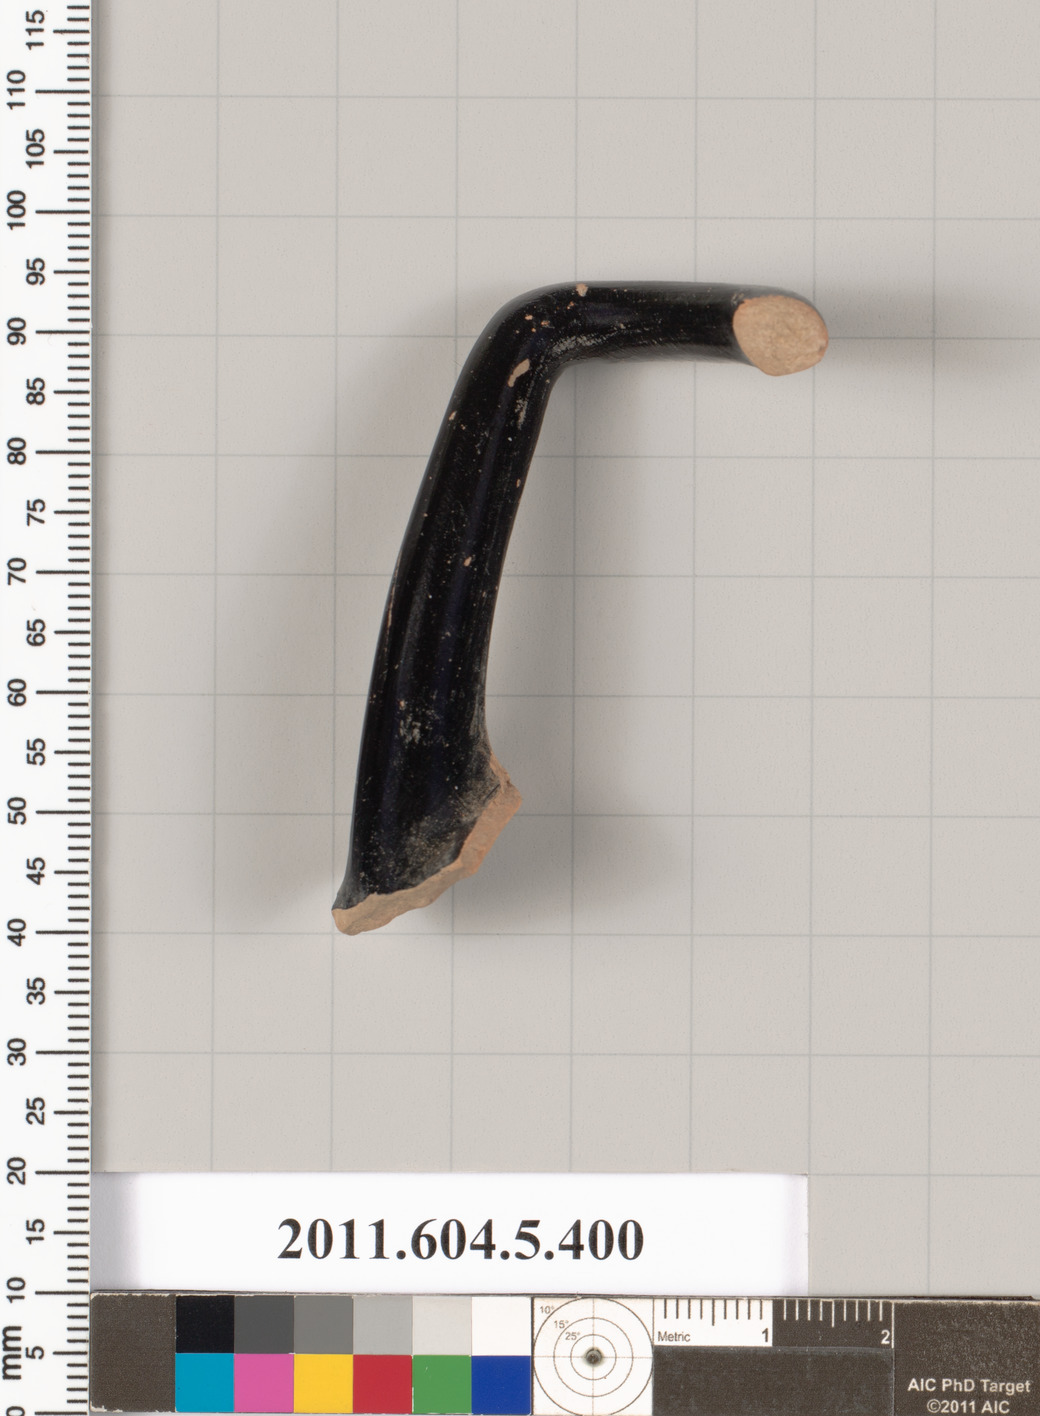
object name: kylix fragment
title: Terracotta fragment of a kylix (drinking cup)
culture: greek, attic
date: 600-401 BCE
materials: terracotta